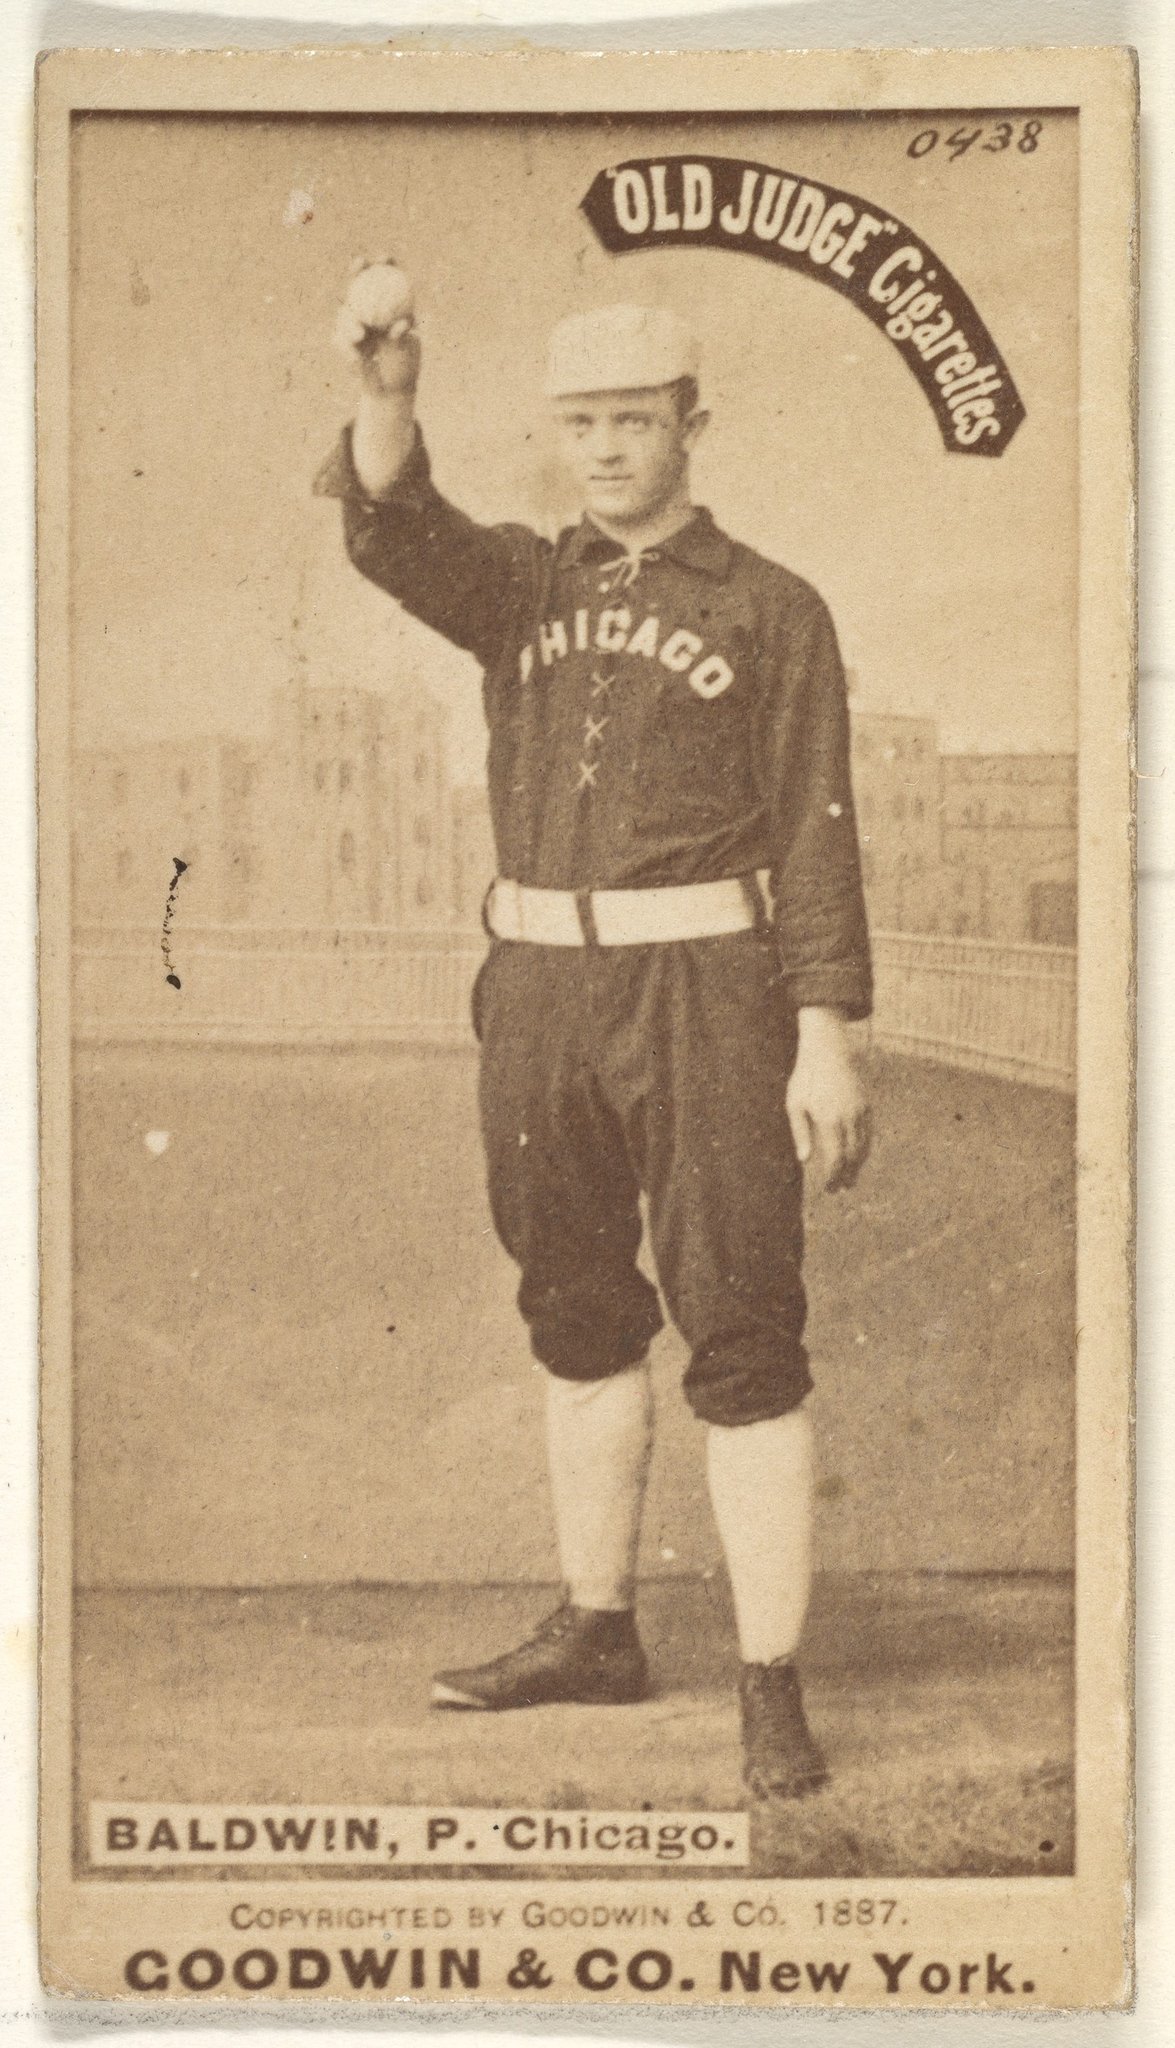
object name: baseball card, photograph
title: Baldwin, Pitcher, Chicago, from the Old Judge series (N172) for Old Judge Cigarettes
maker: goodwin & company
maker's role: publisher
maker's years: 1850-1950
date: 1887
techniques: albumen silver print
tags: men,baseball,athletes